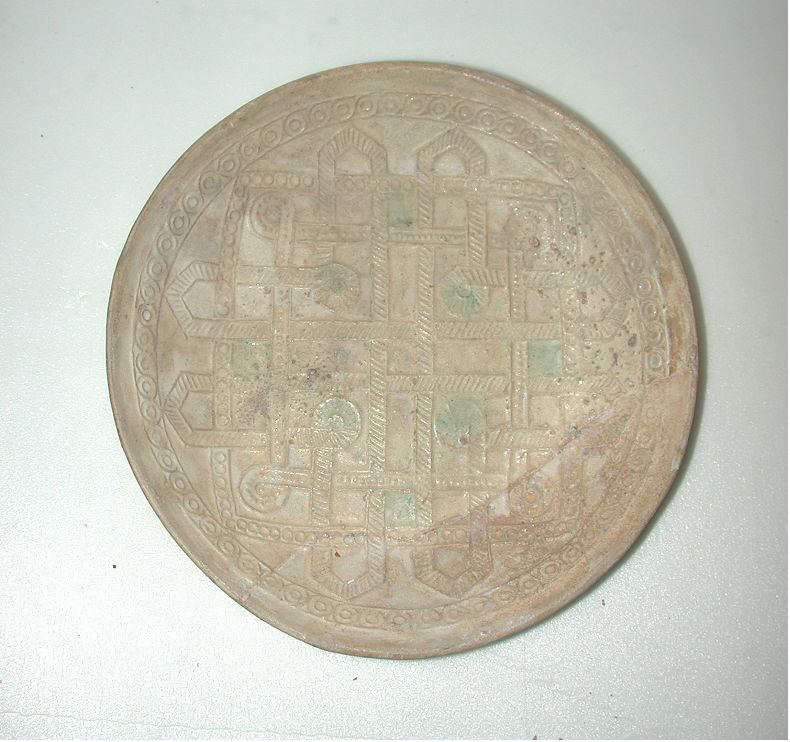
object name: dish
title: Dish with Interlace Designs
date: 801-900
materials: earthenware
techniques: glazing, molding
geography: iraq